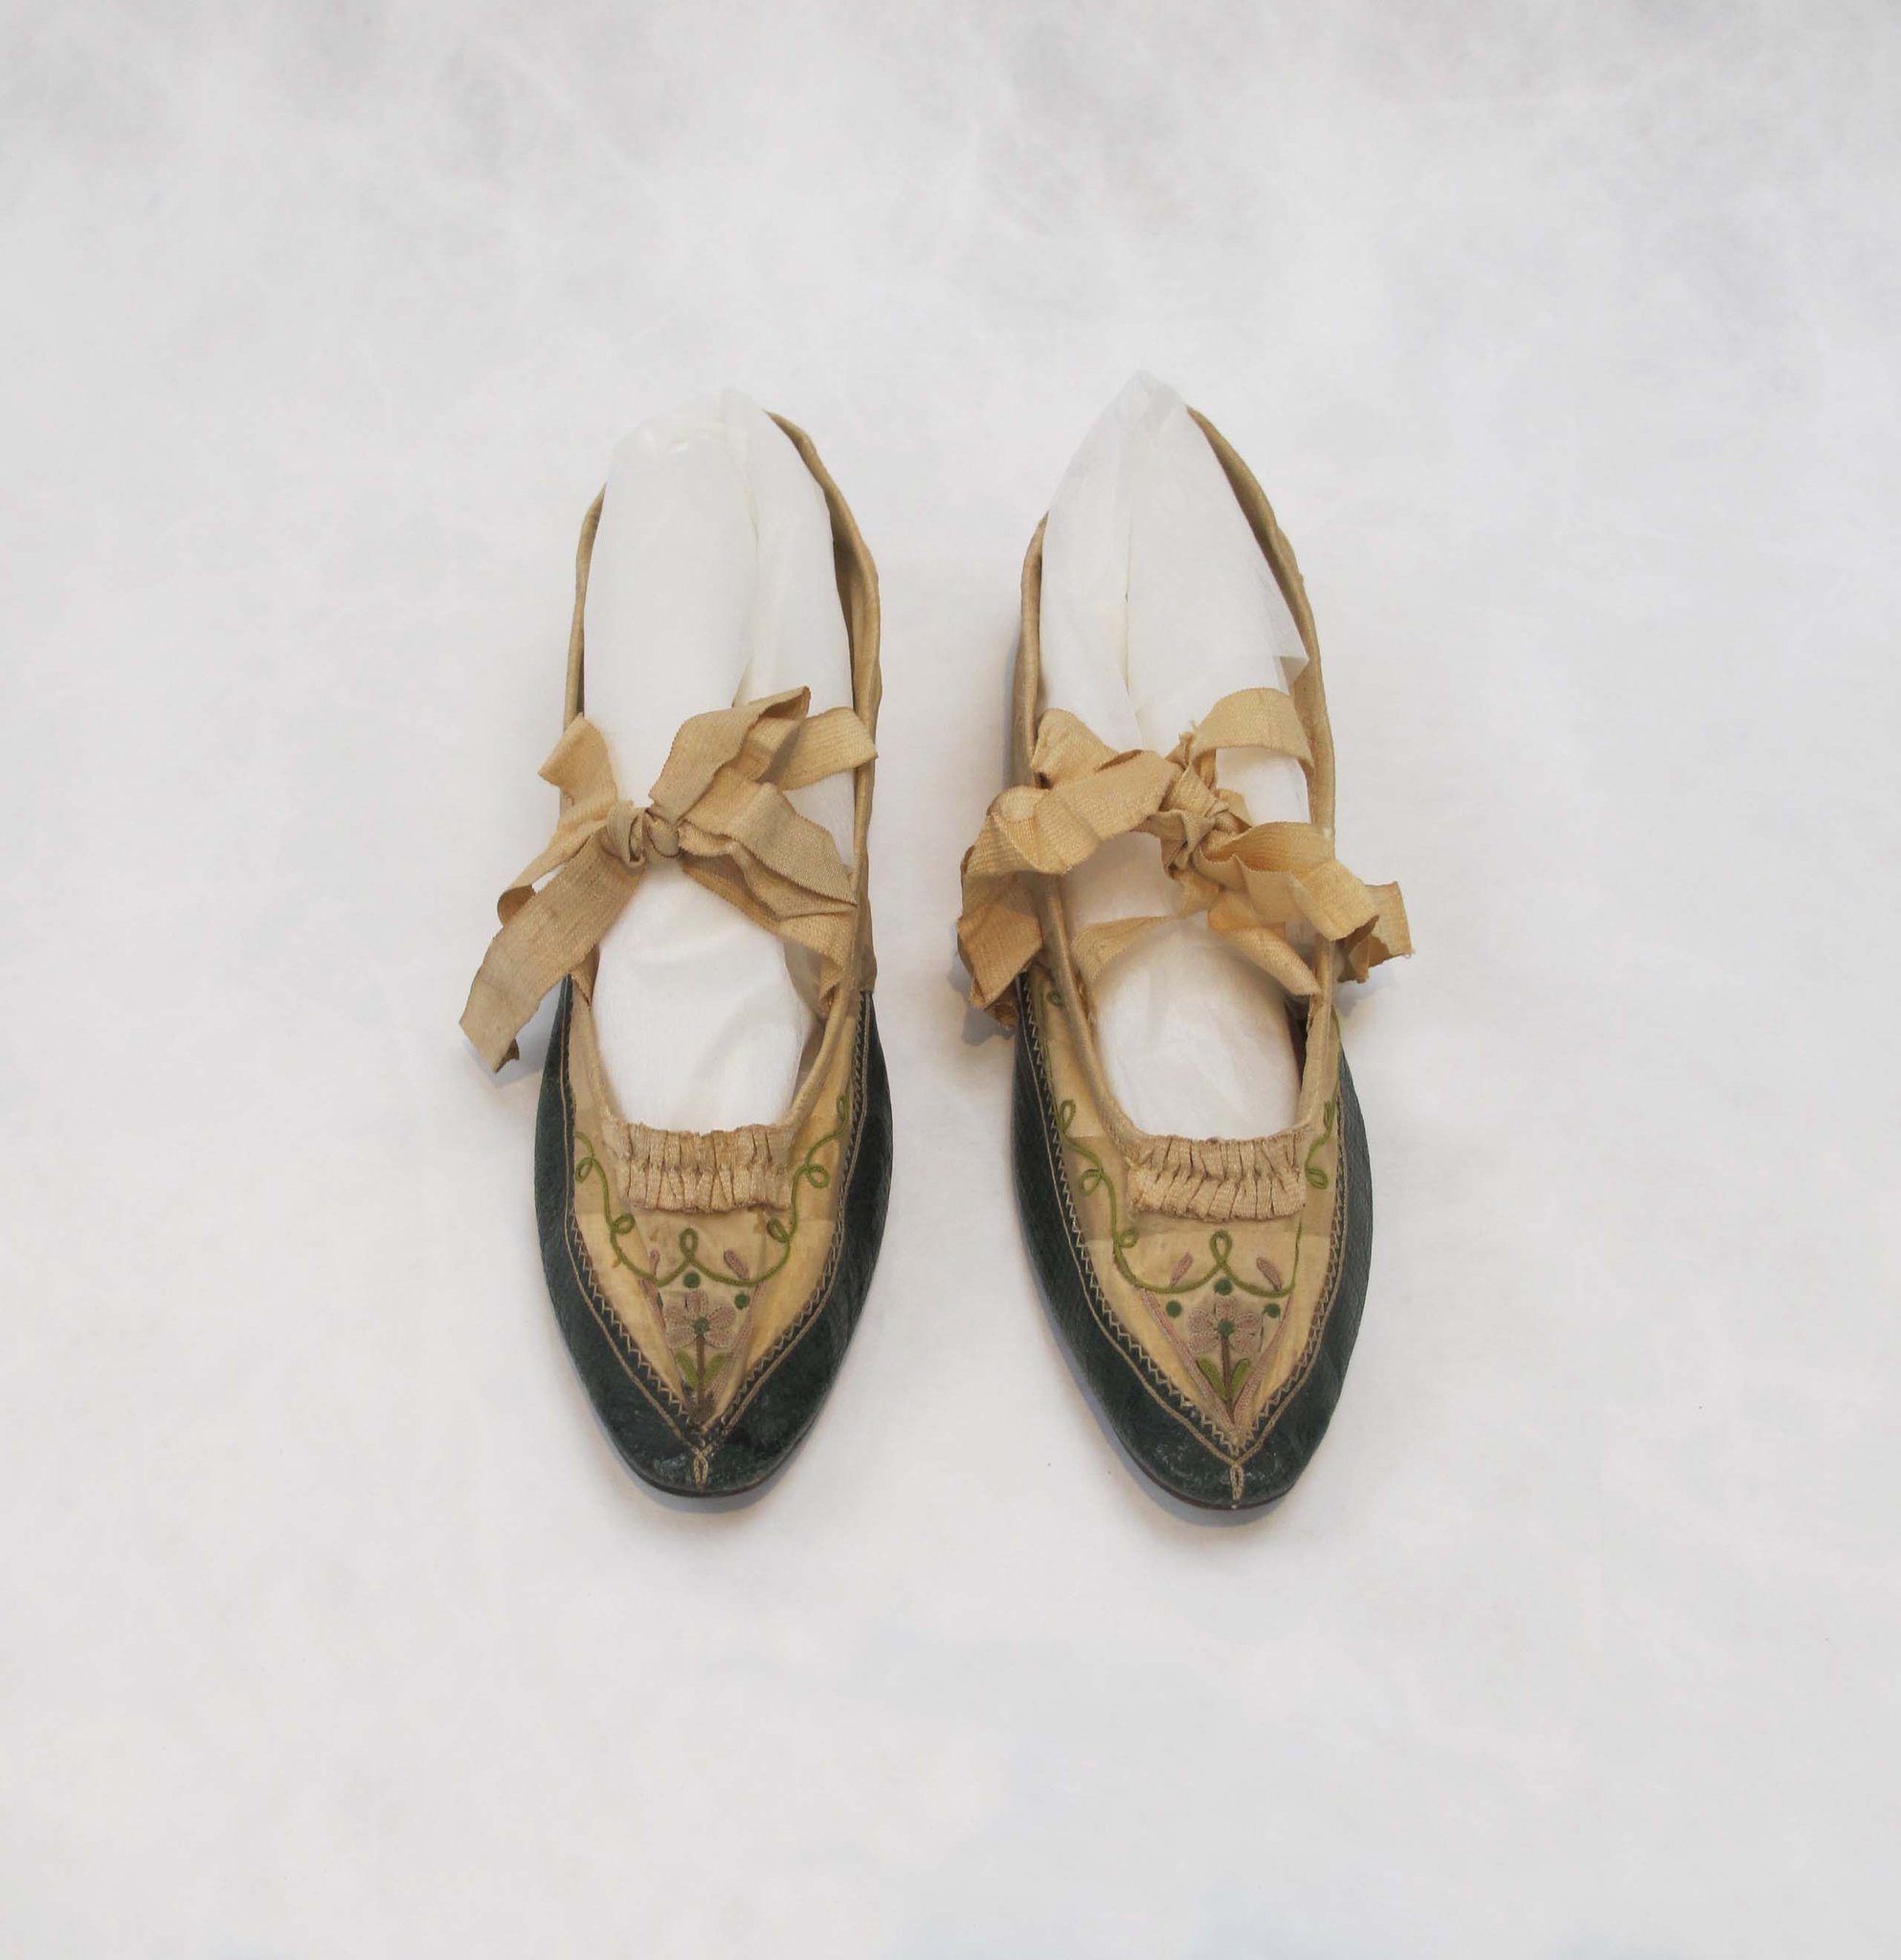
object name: shoe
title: Shoes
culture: french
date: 1800-1810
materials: leather, linen, silk